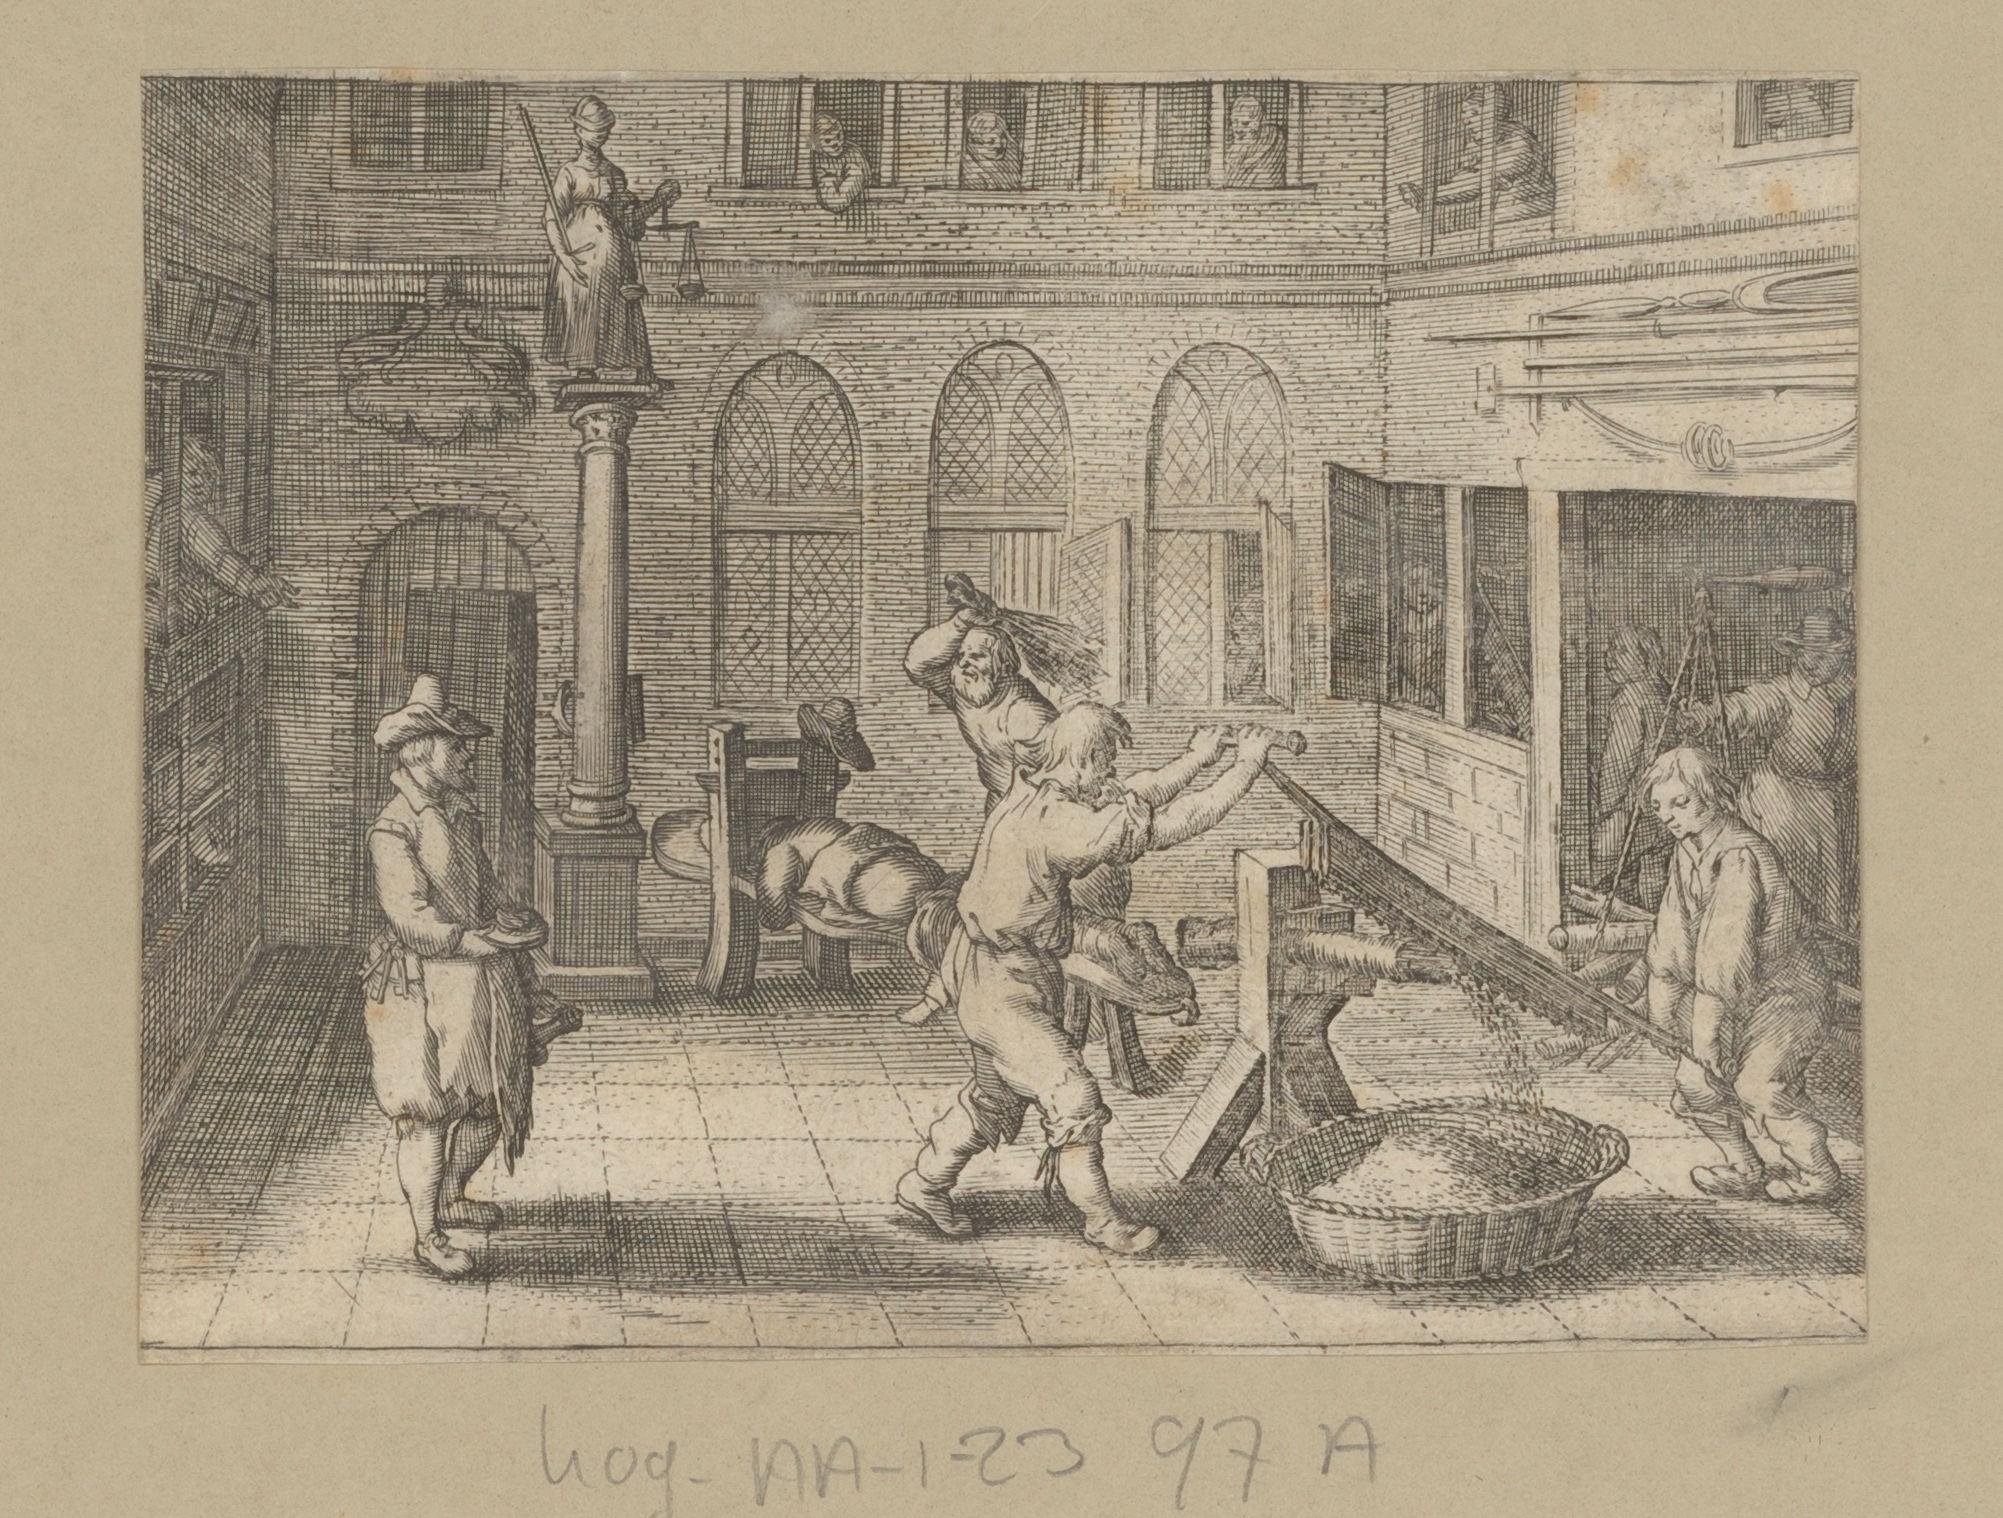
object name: print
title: Gezicht op de binnenplaats van het Rasphuis te Amsterdam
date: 1614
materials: paper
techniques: etching, letterpress printing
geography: northern netherlands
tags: prison, jail, (prisoners) in the prison yard, instruments of torture, execution or punishment: birch rod, justitia (justice) as roman personification, workhouse, penal camp, penitentiary, chain gang, sawing (industrial process)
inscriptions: collector's mark: Lugt 1641b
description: Gezicht op de binnenplaats van het Rasphuis te Amsterdam. Op de voorgrond zijn rechts twee gevangenen hout aan het raspen terwijl links een man toezicht houdt. Op de achtergrond, rechts van het beeld van Justitia, krijgt een gevangene de roede. Onderwerpsrubriek binnen de Atlas Amsterdam: Rechtswezen.